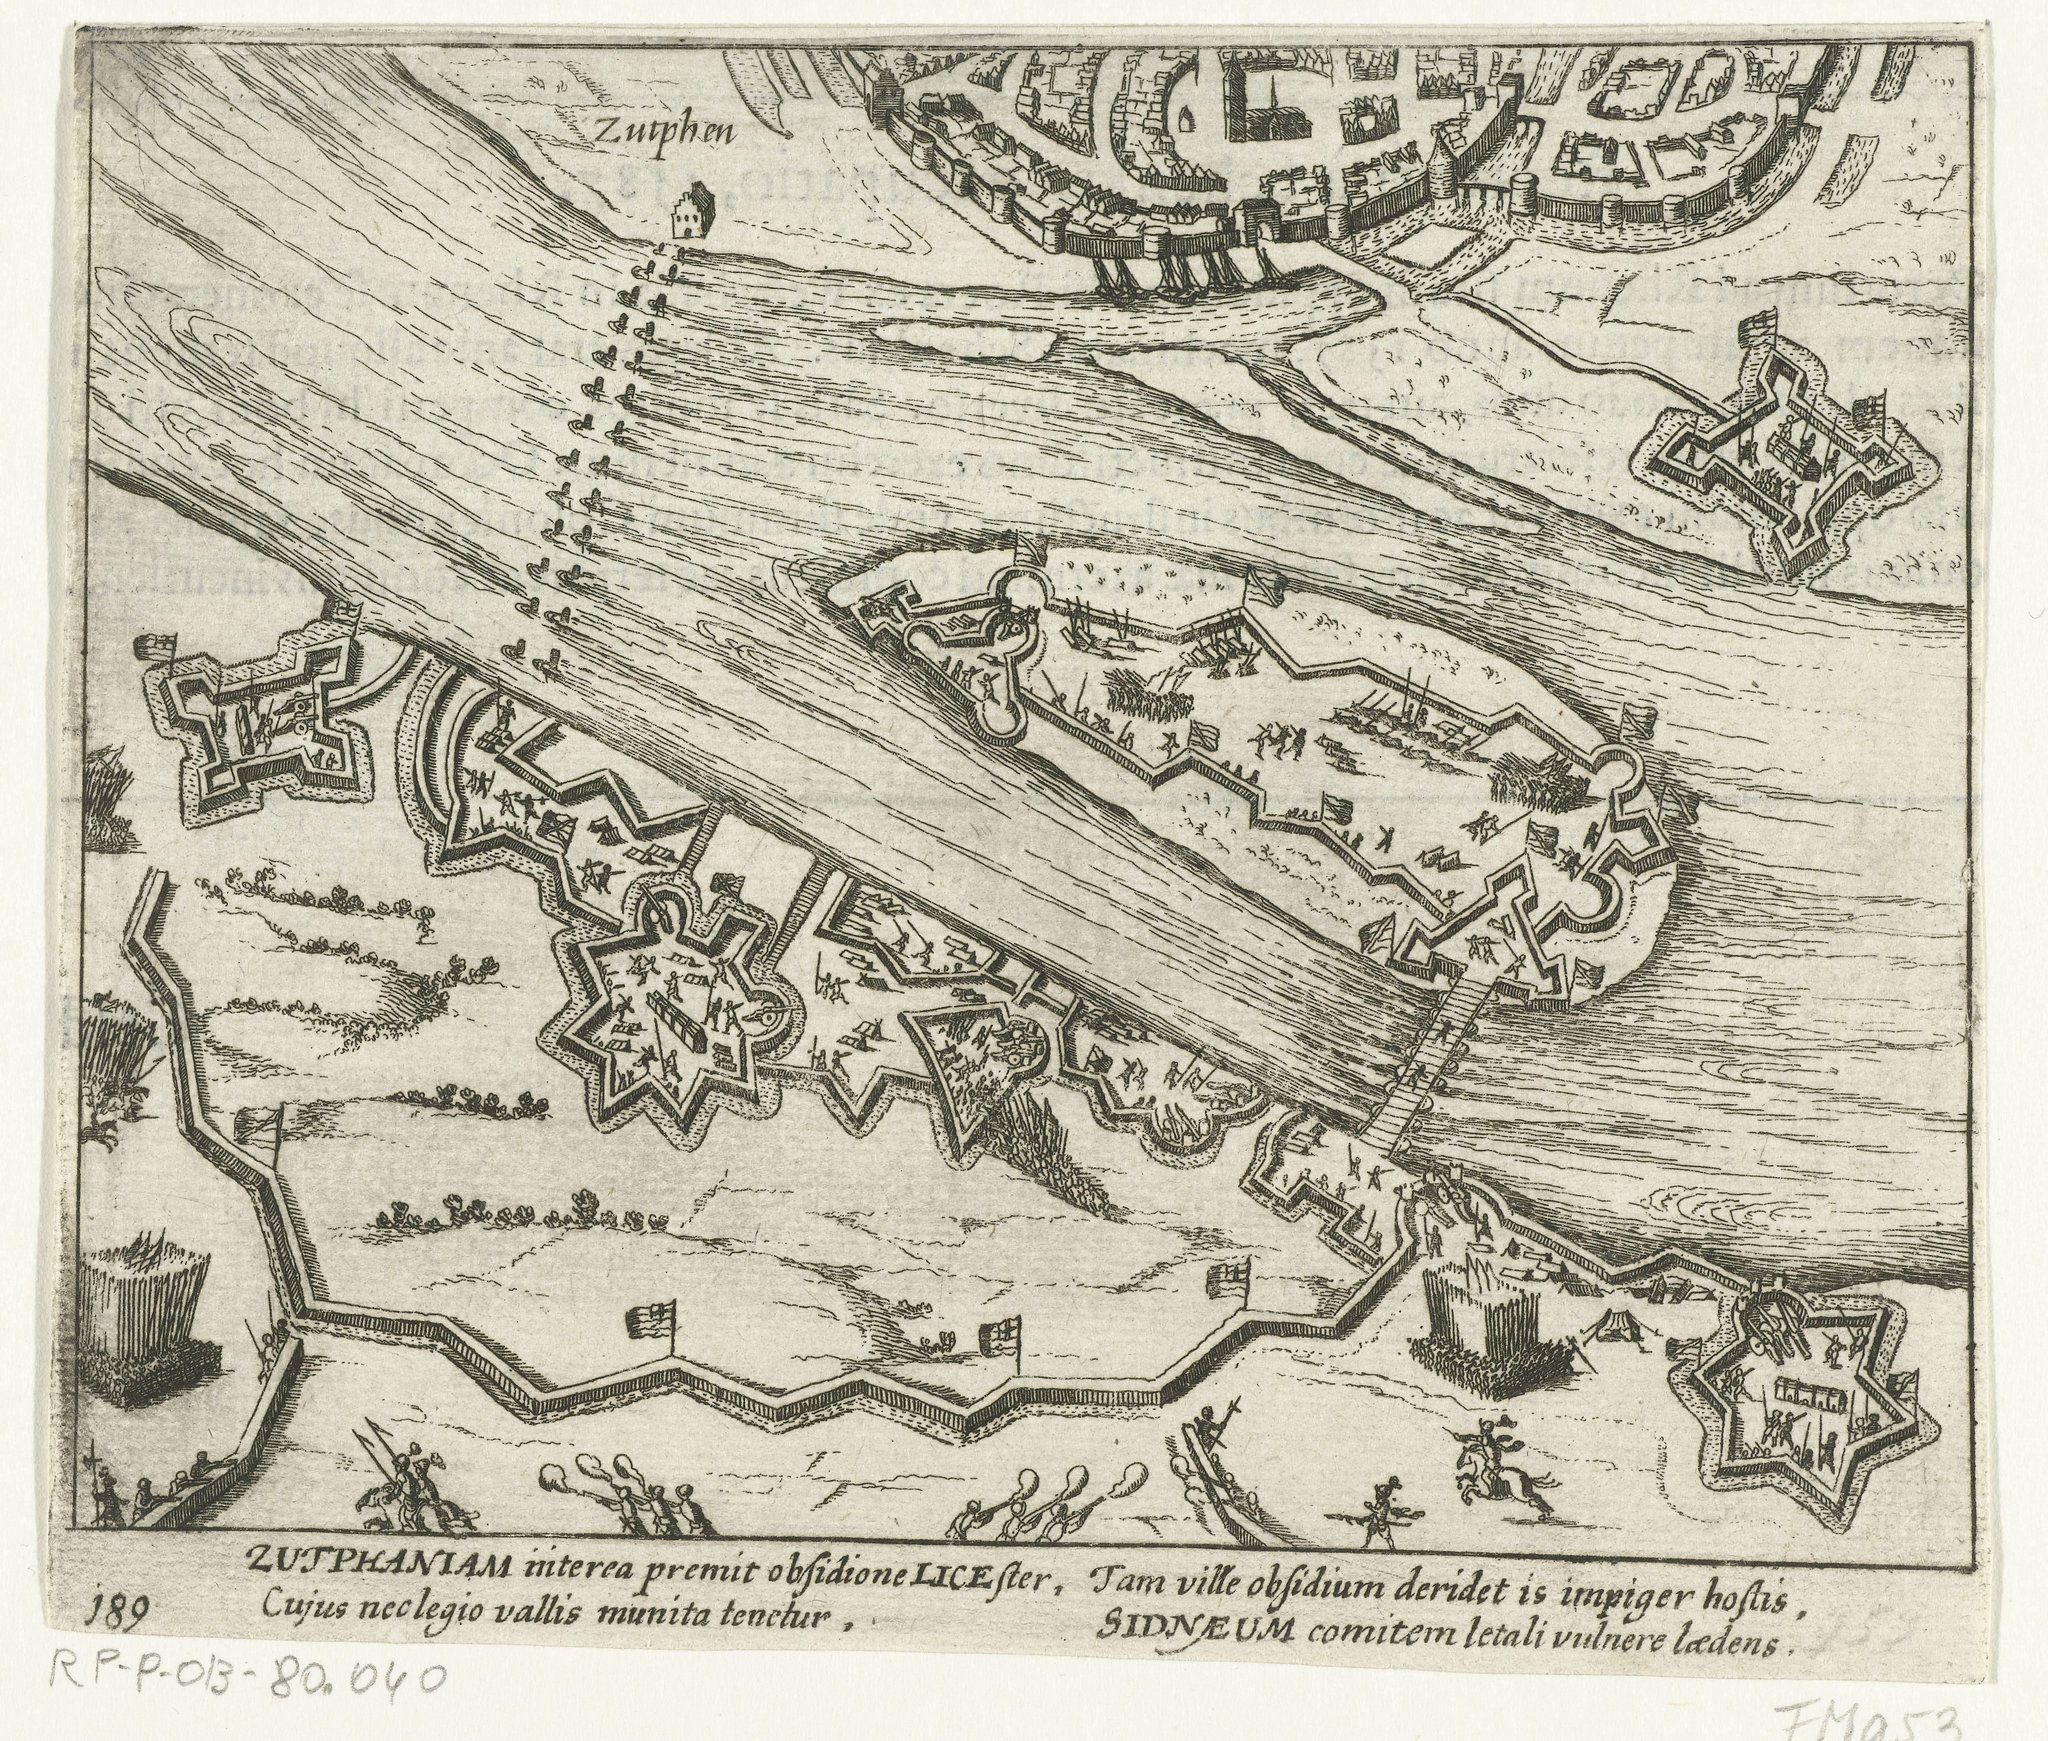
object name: history print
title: Beleg van Zutphen door Leicester, 1586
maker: simon frisius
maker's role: print maker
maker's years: 1570-1628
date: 1613-1615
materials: paper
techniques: etching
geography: northern netherlands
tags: siege, position war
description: Beleg van Zutphen door de troepen van de graaf van Leicester, september en oktober 1586. Gezicht op Zutphen en de Engelse en Spaanse schansen langs de IJssel. Met onderschrift van 4 regels in het Latijn. Genummerd 189. Bedrukt op achterzijde met tekst in het Latijn.